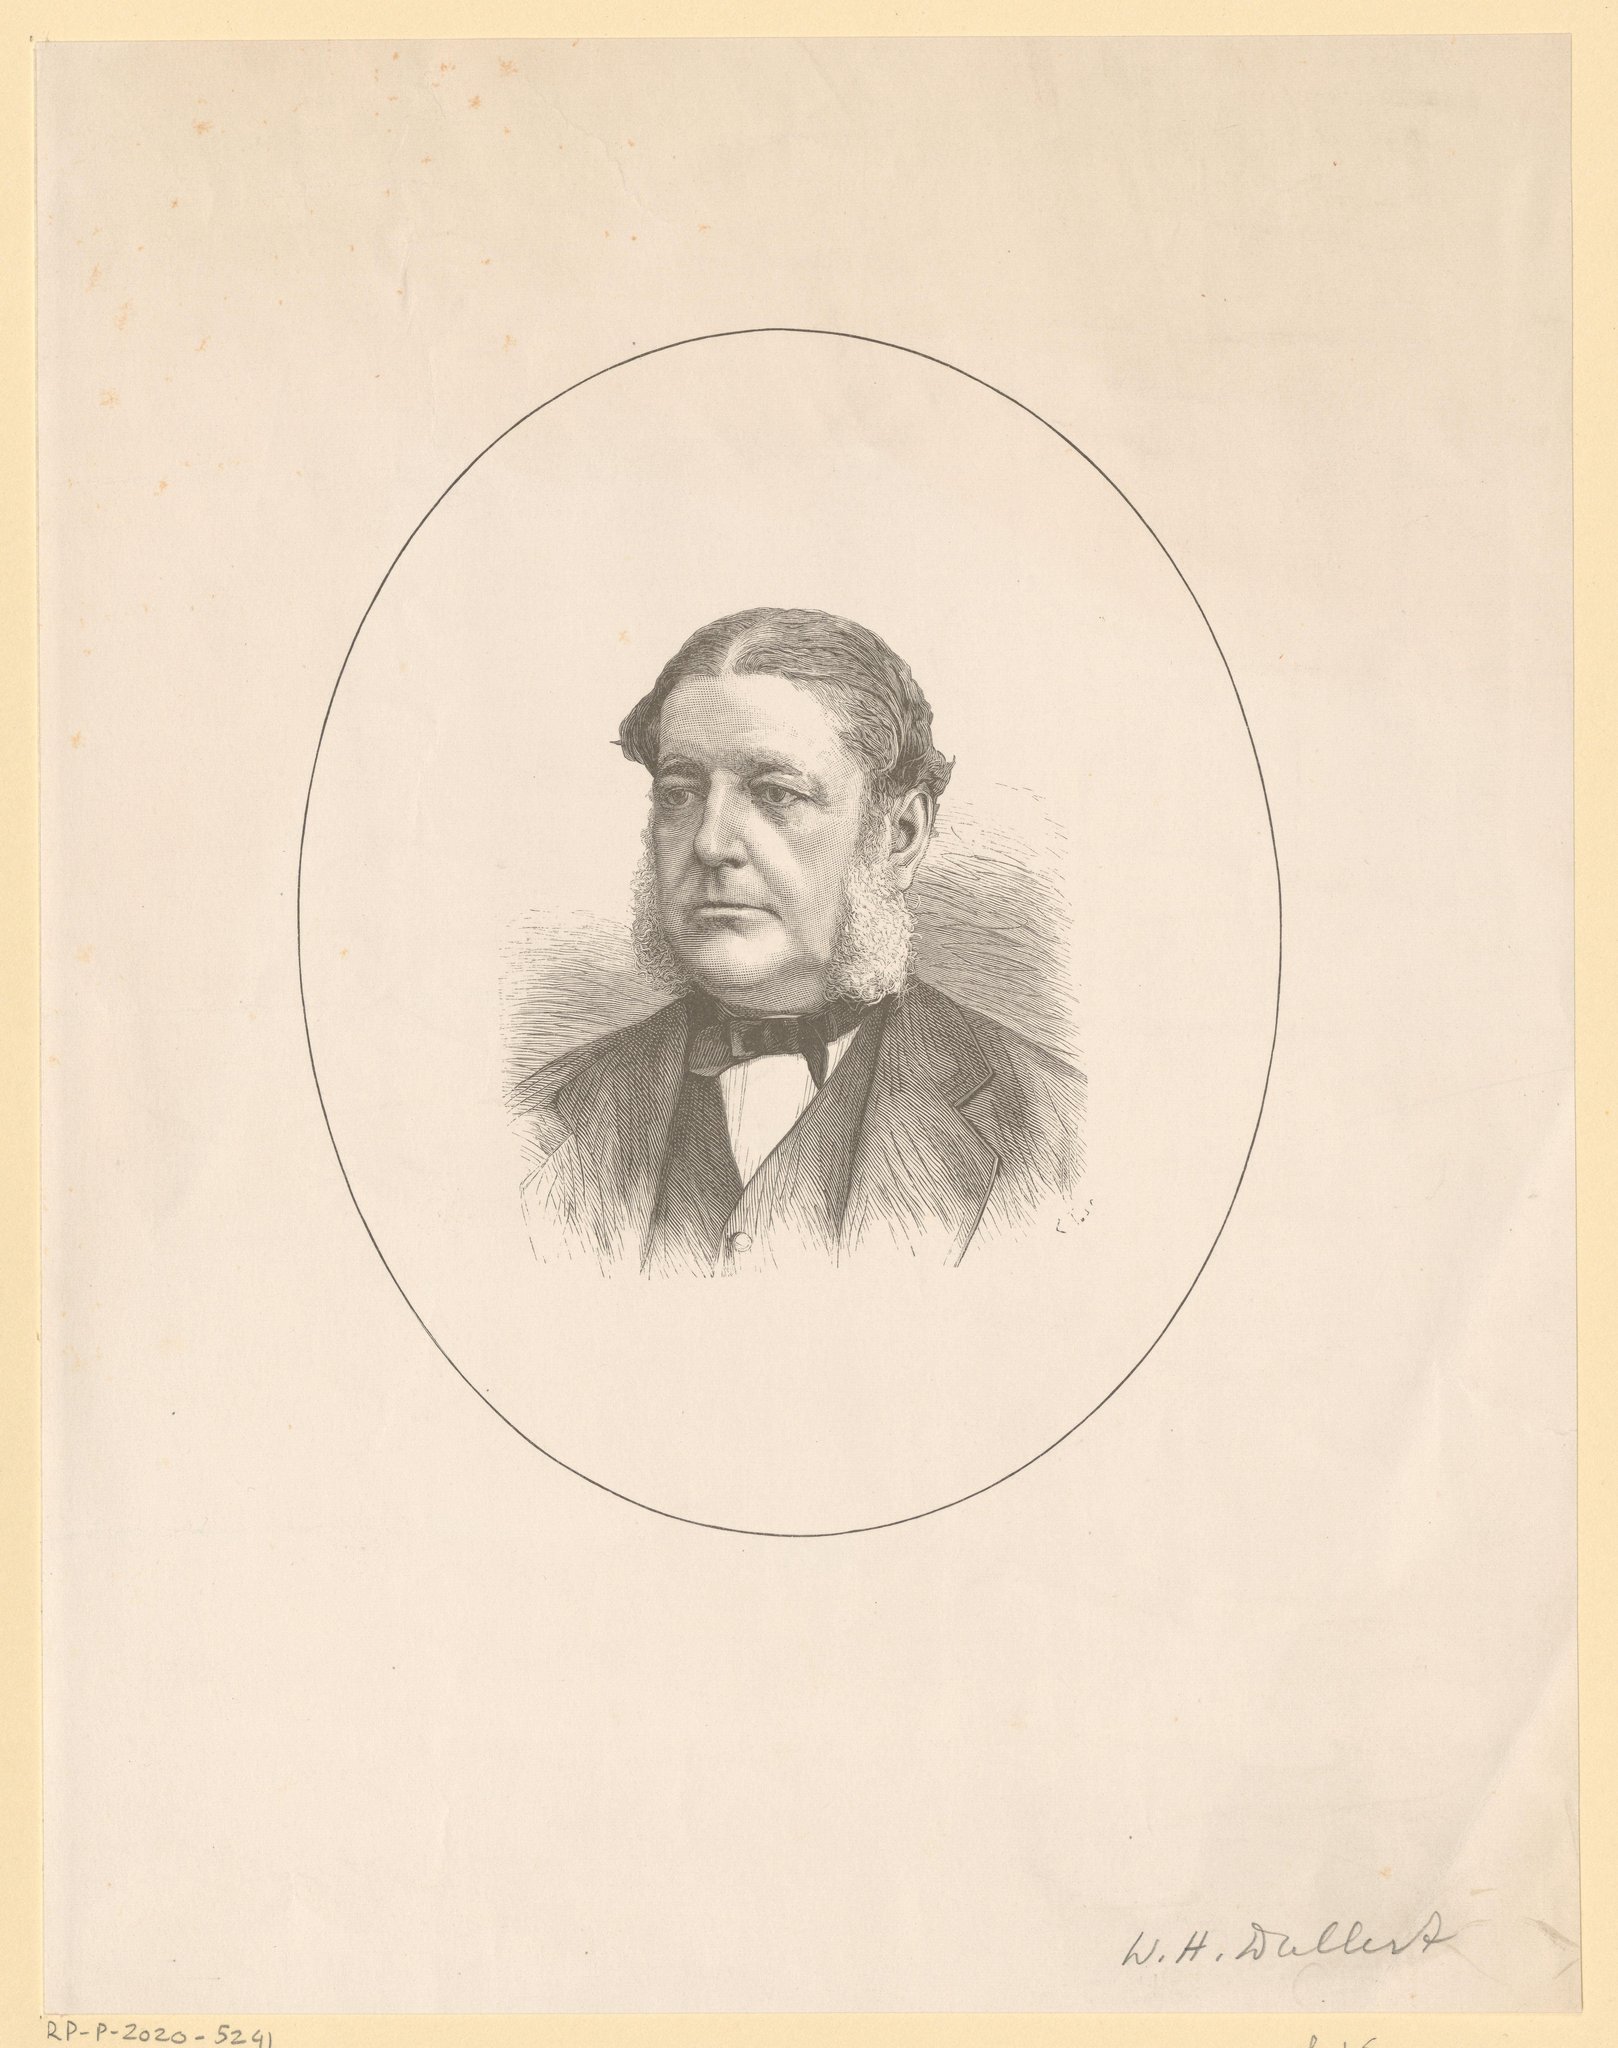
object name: print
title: Portret van Willem Hendrik Dullert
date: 1879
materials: paper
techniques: engraving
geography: haarlem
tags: historical persons, politician, e.g. party leader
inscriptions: monogram: ‘[...]T.[...]’, collector's mark: Lugt 2228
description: Prent met tekst op verso gebruikt in: Eigen haard, nr. 38, 1879, p. 377.